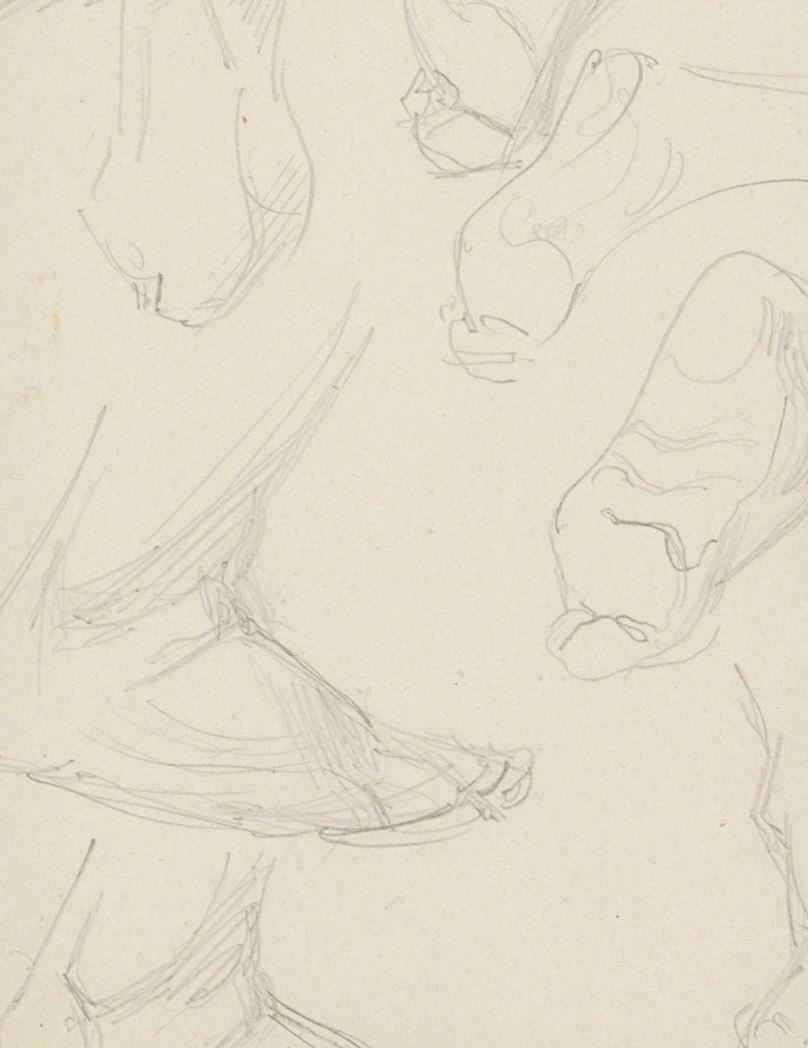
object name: sketchbook leaf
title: Voeten, voetzolen en een hand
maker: reijer stolk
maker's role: draughtsman, print maker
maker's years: 1896-1945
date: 1906-1945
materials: paper, pencil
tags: hand, foot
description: Blad 55 recto uit een schetsboek met 69 bladen.